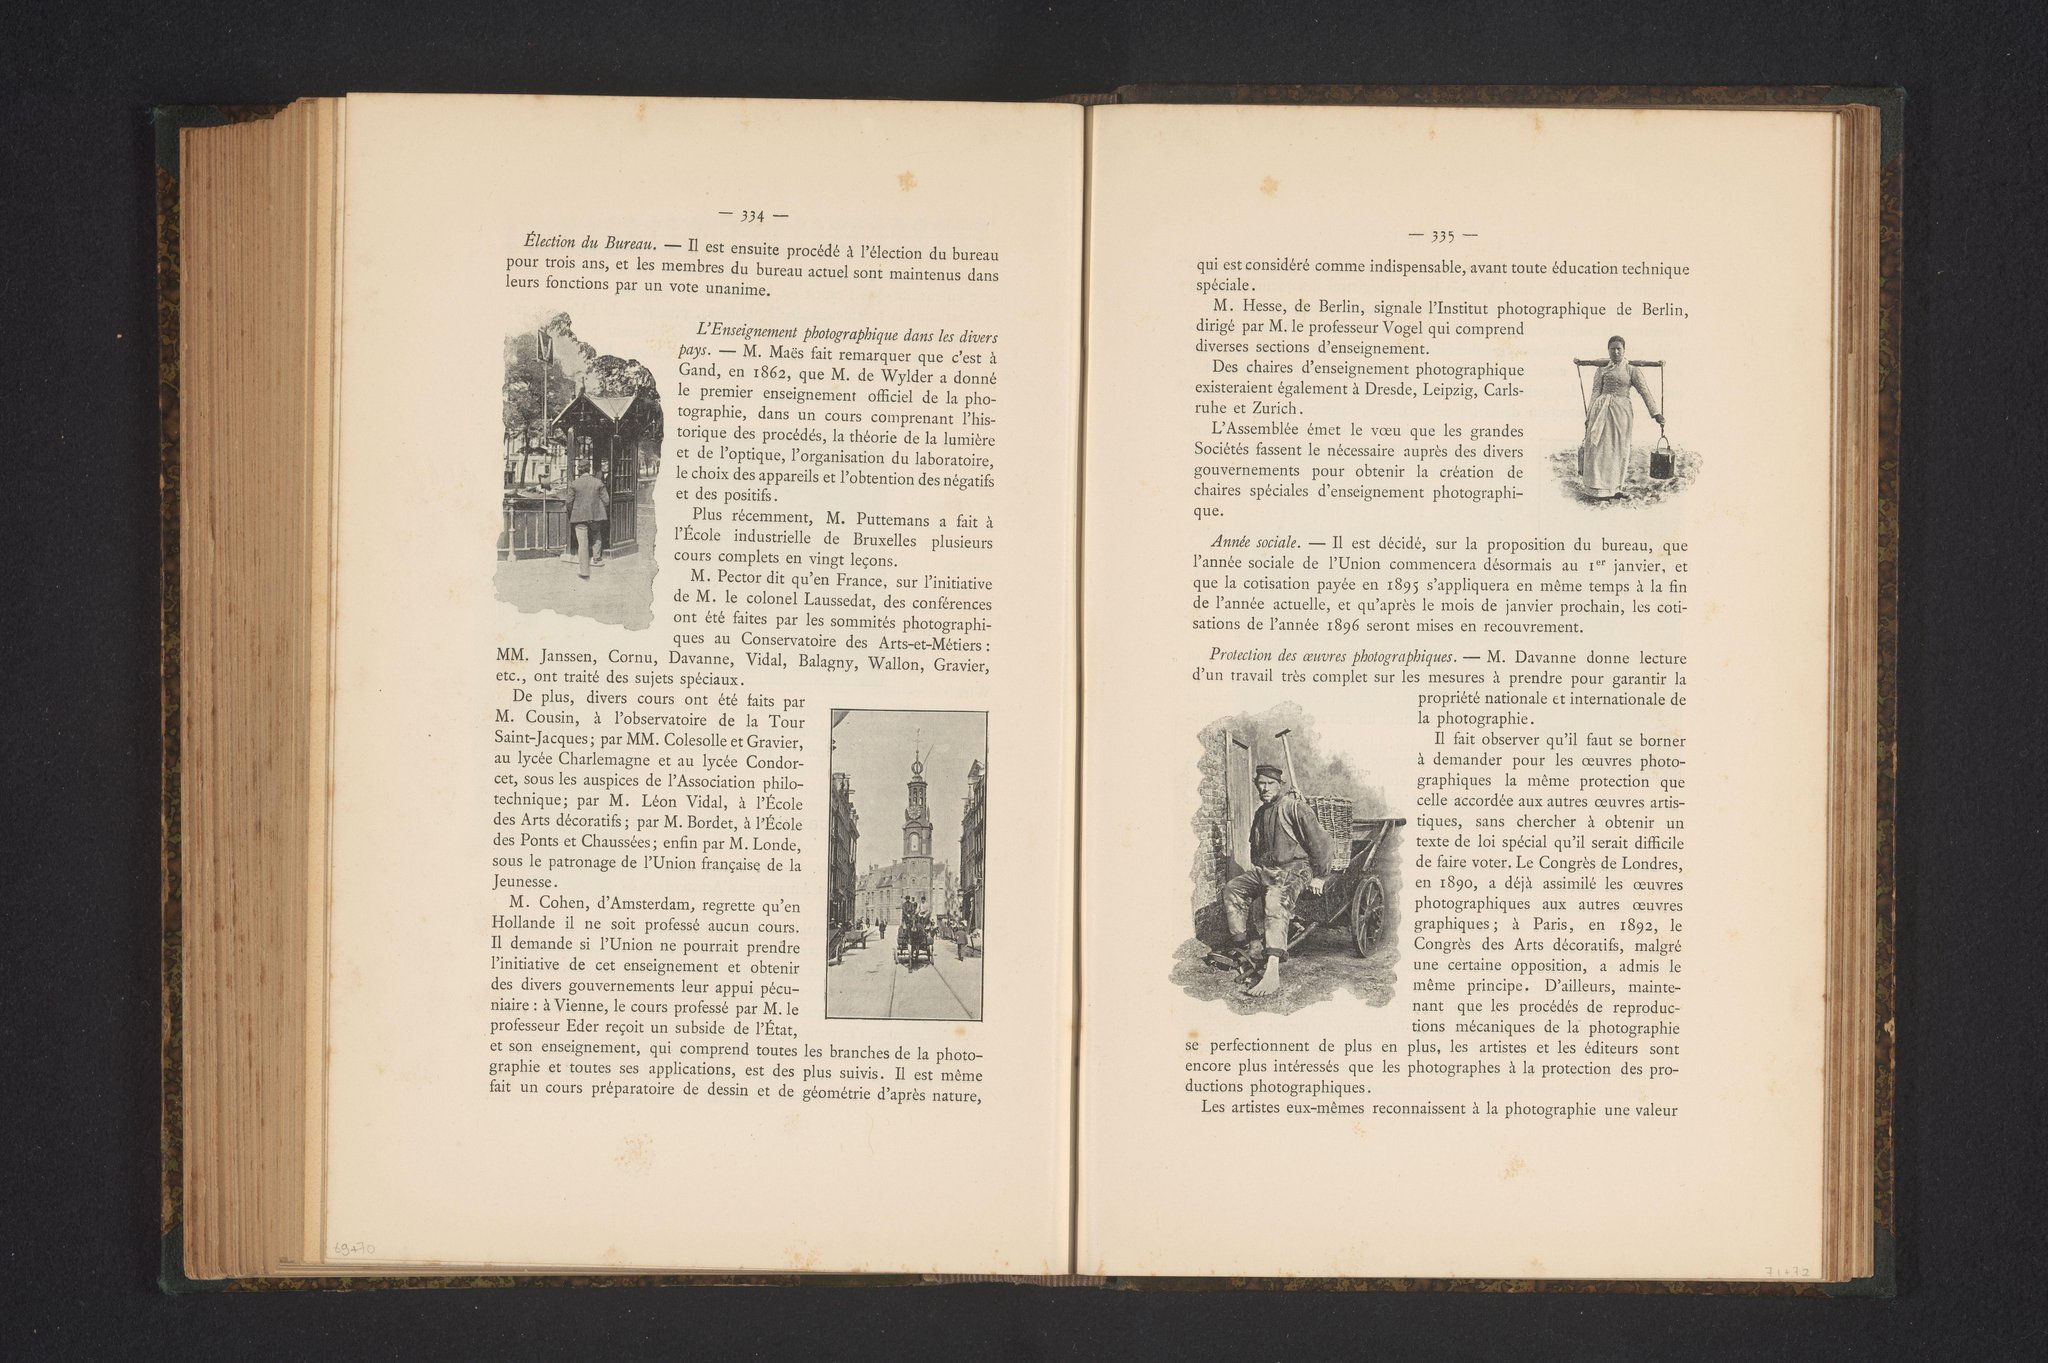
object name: page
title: Verkoopster van room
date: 1890-1895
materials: paper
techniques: autotype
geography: zandvoort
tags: dairy products, merchant, salesman - bb - women engaged in trade and commerce